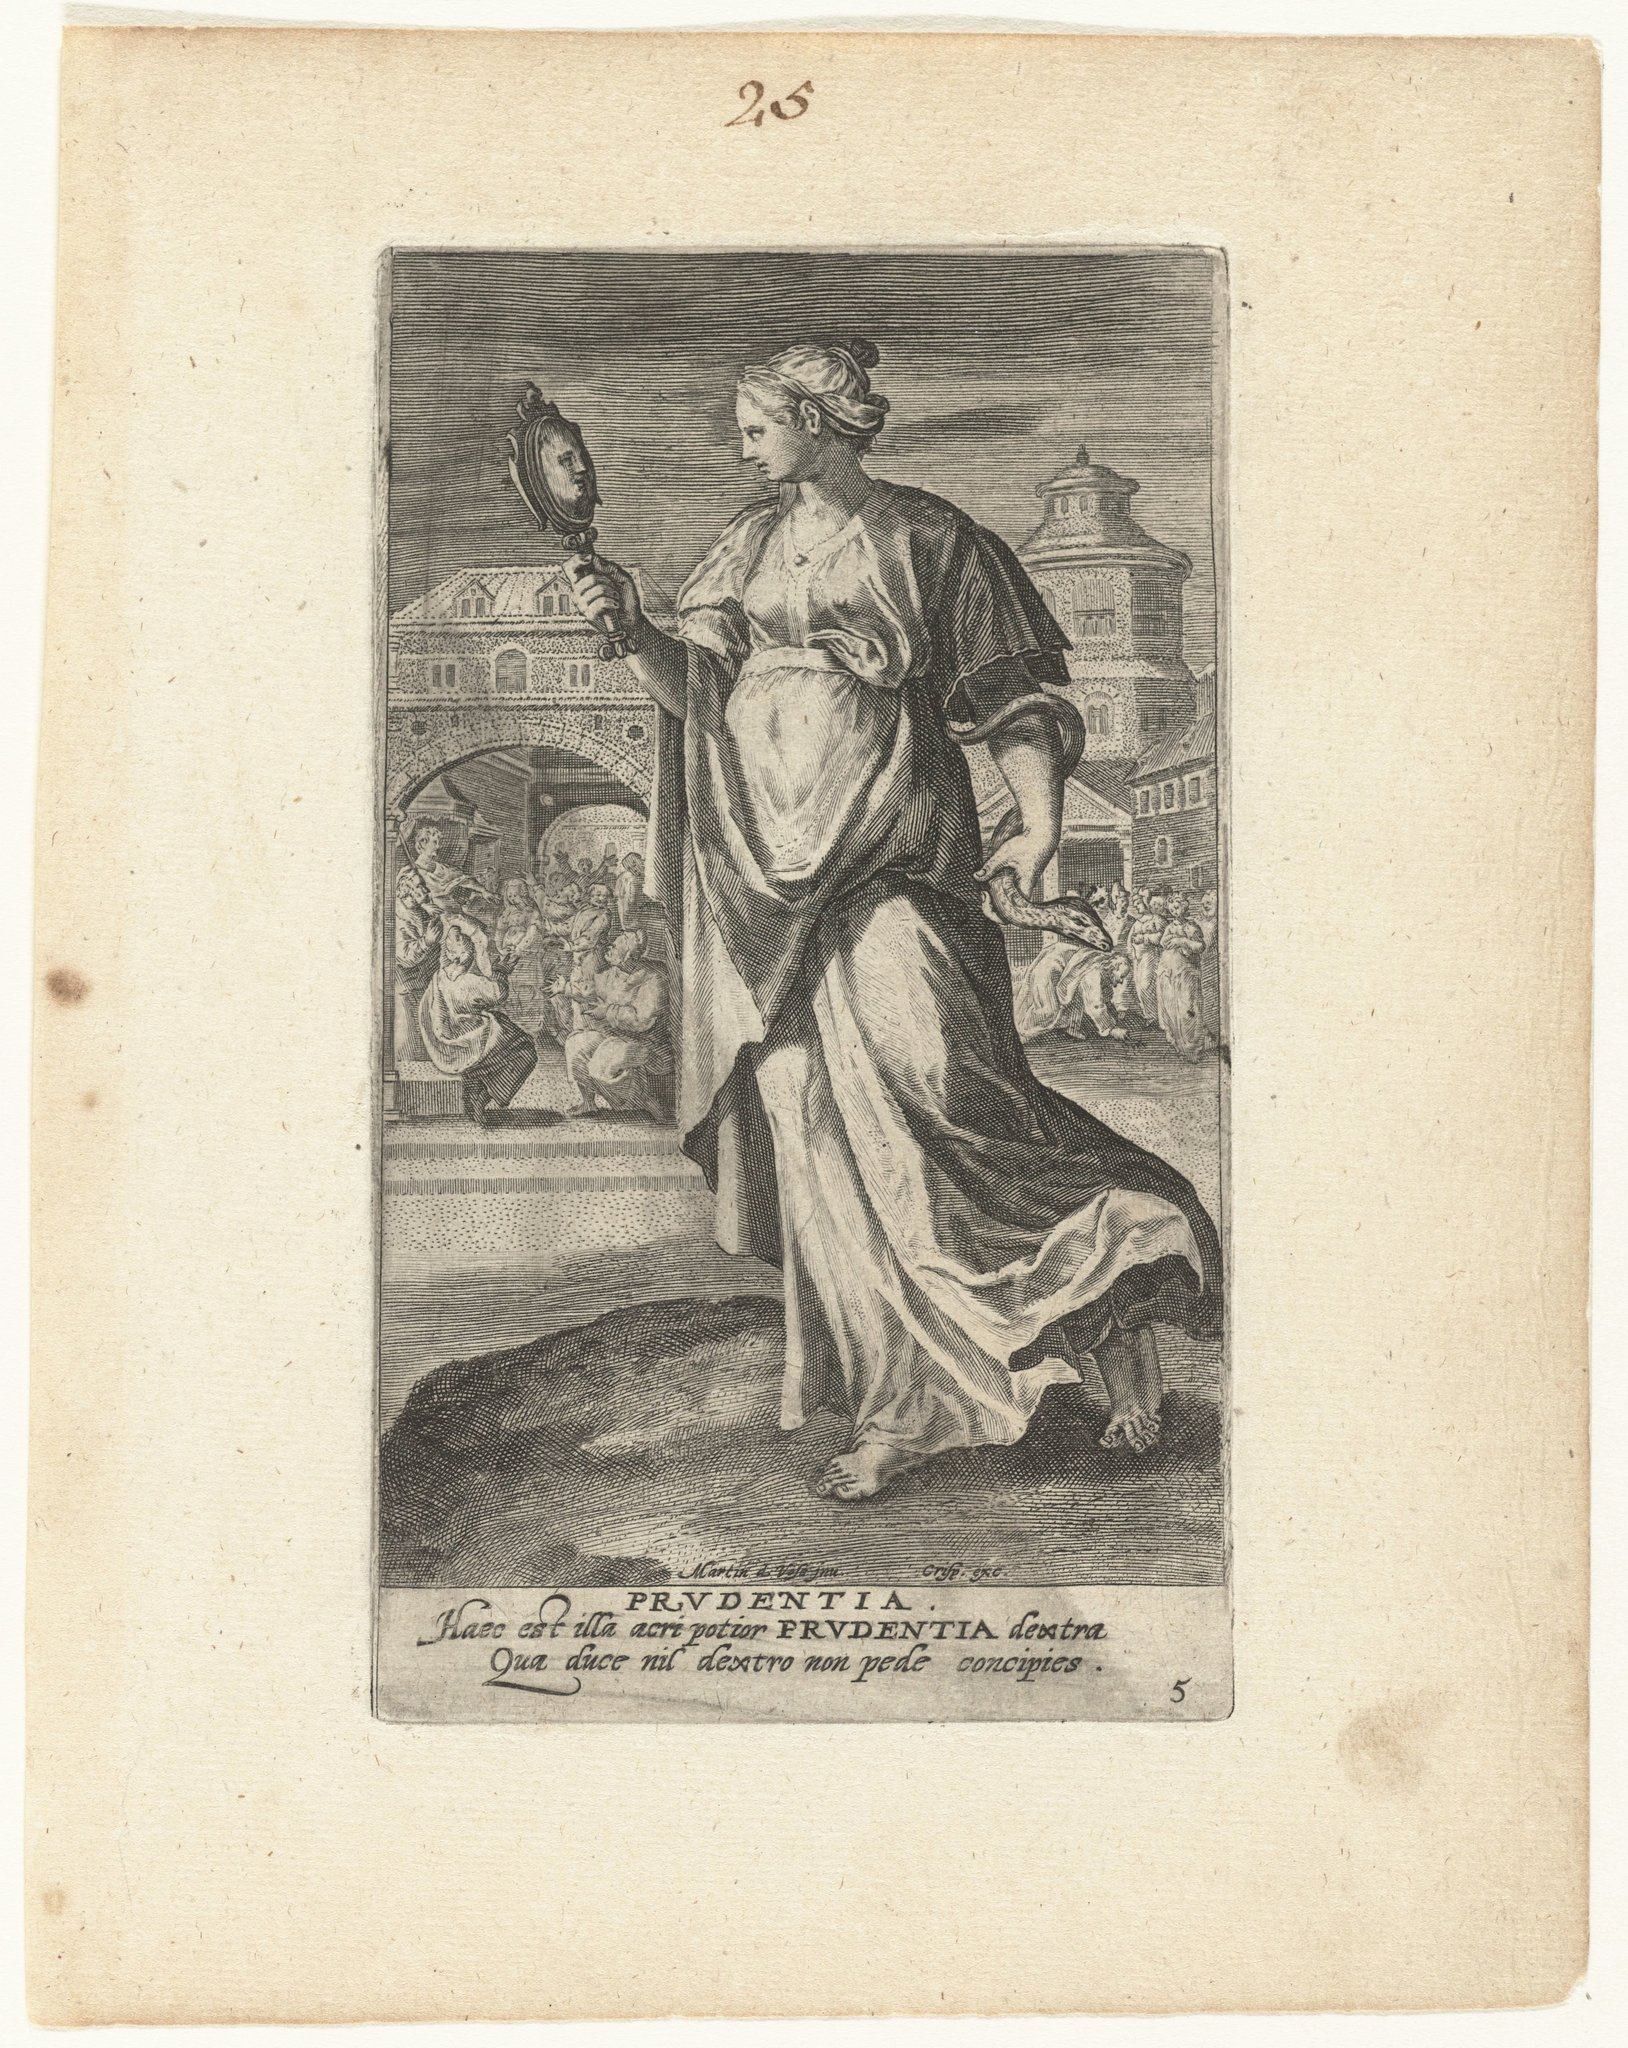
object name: print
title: De zeven deugden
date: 1580-1588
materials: paper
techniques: engraving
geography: antwerp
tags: prudence, 'prudentia'; 'prudenza' (ripa) ~ one of the four cardinal virtues, christ points to or writes on the ground, the story of susanna and the elders (in which the youth daniel intervenes on behalf of susanna) (daniel 13)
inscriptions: collector's mark: Lugt 2228, number: ‘25’, collector's mark: Lugt 2760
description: De vrouwelijke personificatie van Voorzichtigheid (Prudentia), een van de vier kardinale deugden. In haar handen draagt ze haar persoonlijke attributen: de spiegel en de slang. Links op de achtergrond mogelijk Daniël die de onschuld van Susanna bewijst. Rechts op de achtergrond Christus en de overspelige vrouw (Joh. 8:1-11). In de marge een tweeregelig onderschrift in het Latijn. Vijfde prent uit een serie met deugden.